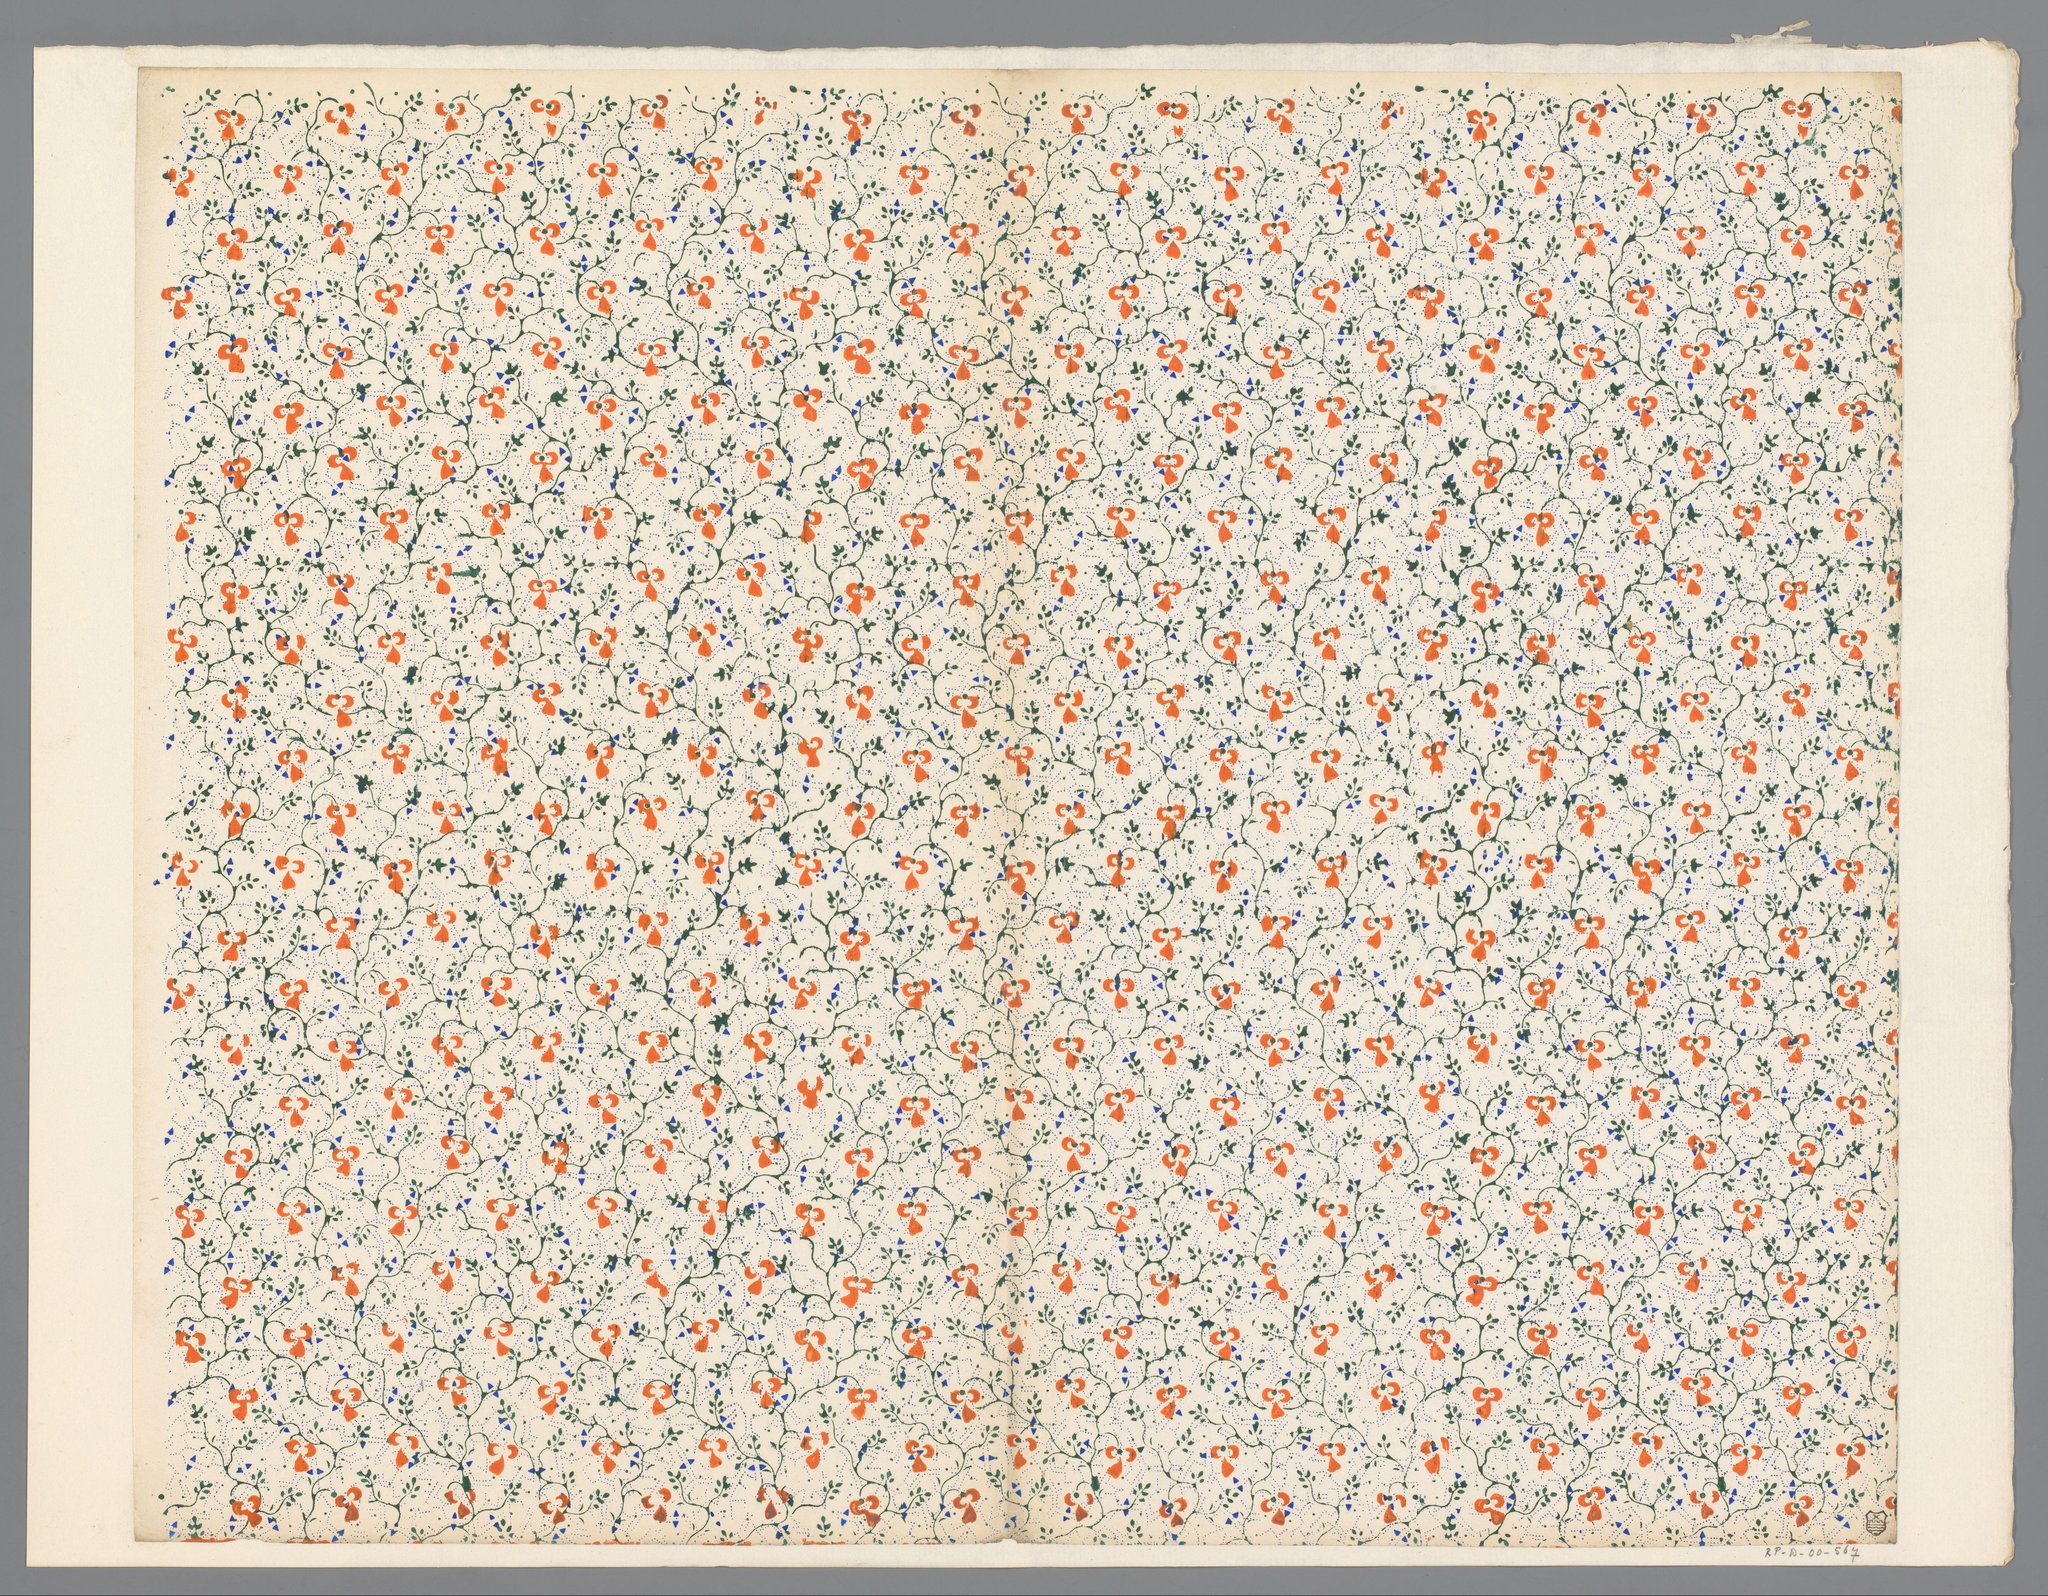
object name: wrapper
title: Blad met strooipatronen van fantasiemotief en driehoekjes over ranken met bladeren en stippellijnen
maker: Anonymous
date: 1800-1900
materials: paper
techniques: printing block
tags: ornament derived from plant forms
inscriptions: collector's mark: Lugt 2760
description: Blad met strooipatronen van een driedelig fantasiemotief en driehoekjes over ranken met bladeren en stippellijnen. Gebruikt als omslag.